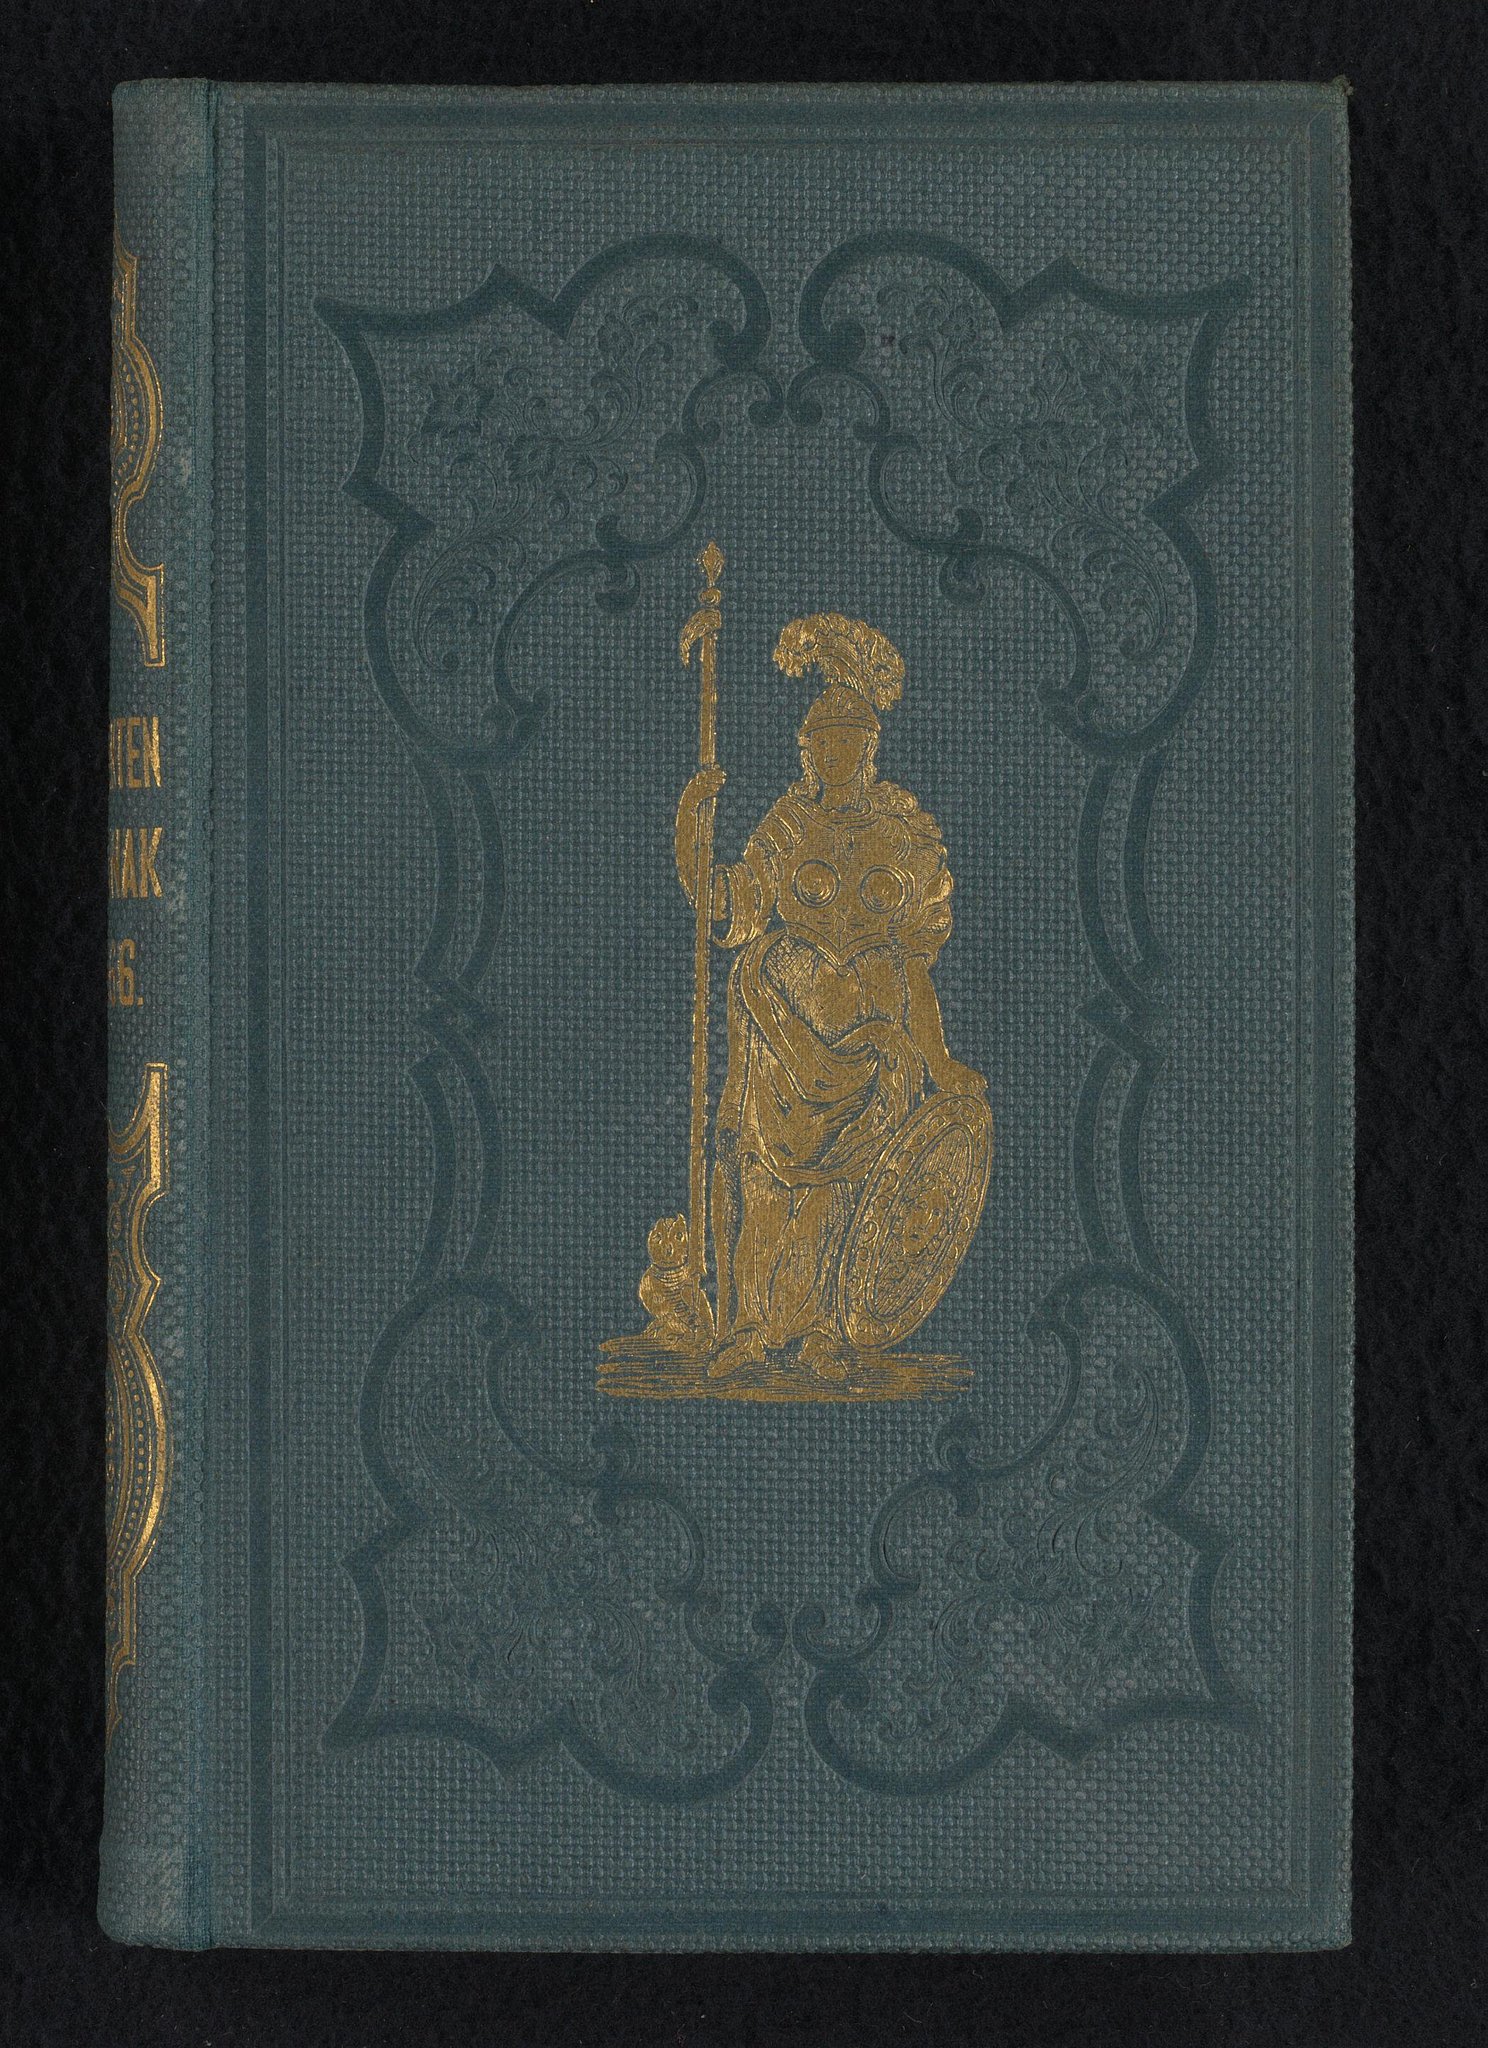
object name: book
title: Utrechtsche studenten-almanak voor het jaar 1866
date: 1865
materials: paper, cardboard, linen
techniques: albumen print, letterpress printing, lithograph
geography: utrecht